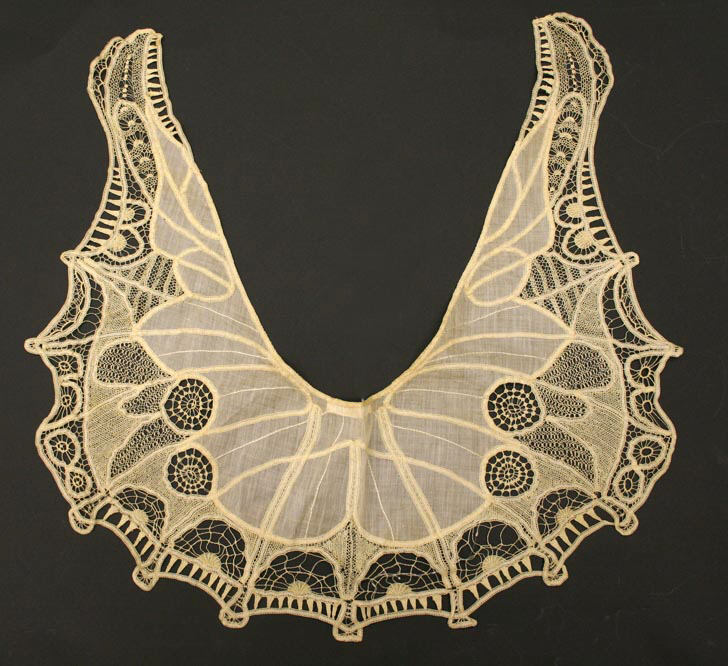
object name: collar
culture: american or european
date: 1890-1899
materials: linen